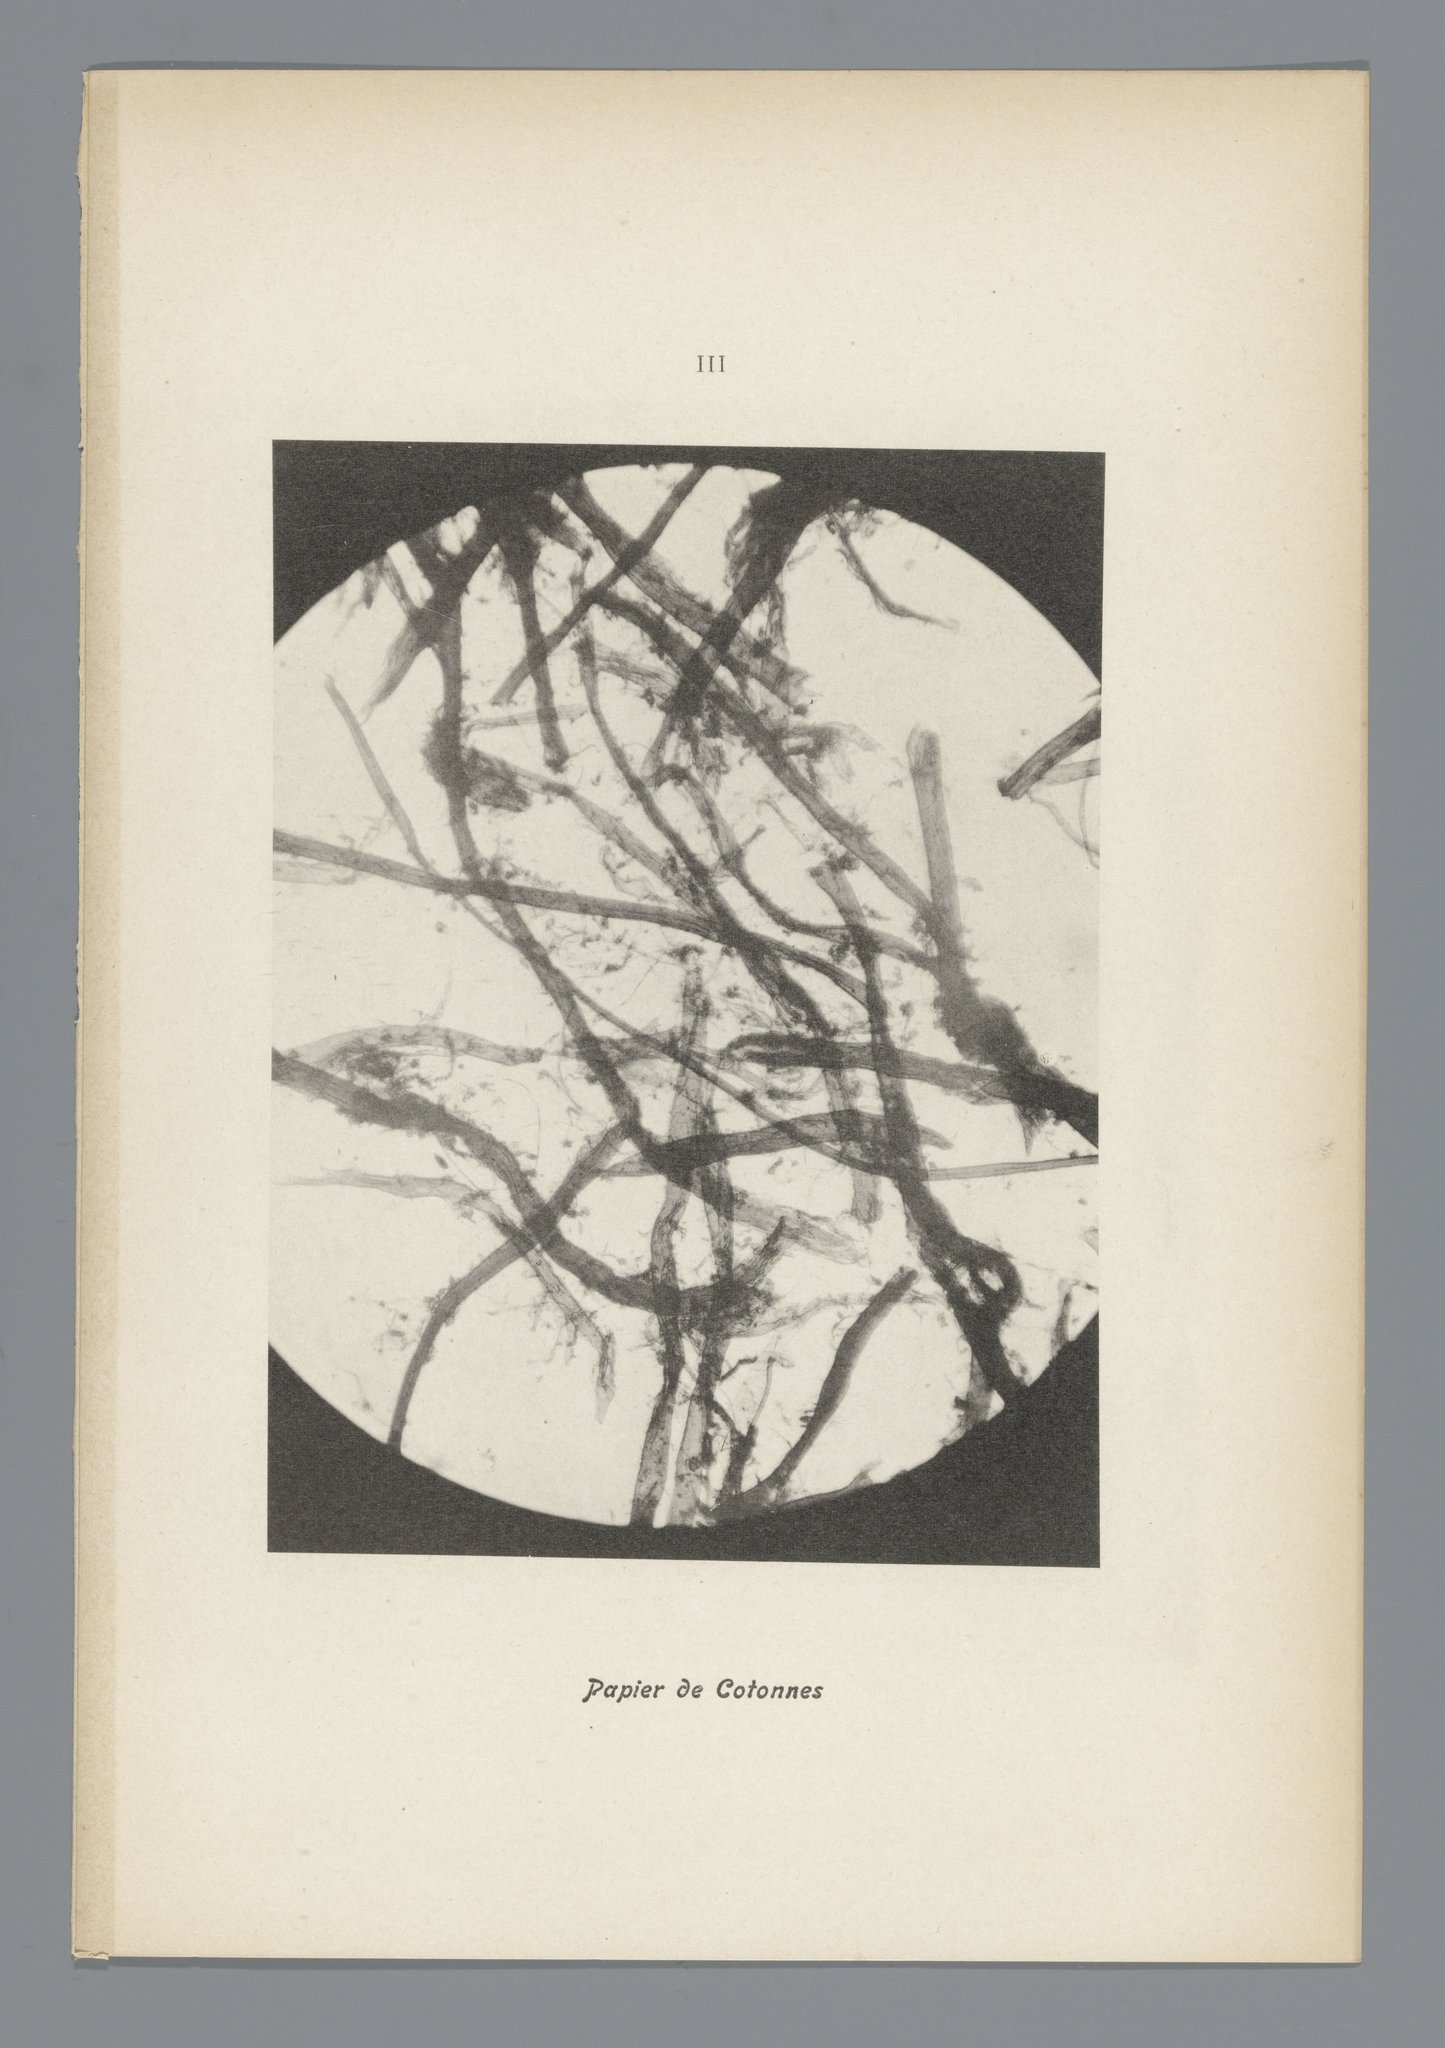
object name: photograph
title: Photomicrographs of Paper Fibres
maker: Anonymous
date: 1900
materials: ink, paper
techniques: photograph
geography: france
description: For science, photography was a useful tool for supplementing or refuting what could be observed with the human eye. The camera, after all, saw more than the eye, and the photographic plate had a better ‘memory’ than man. By combining a microscope and a camera, tiny objects could also be studied closely.